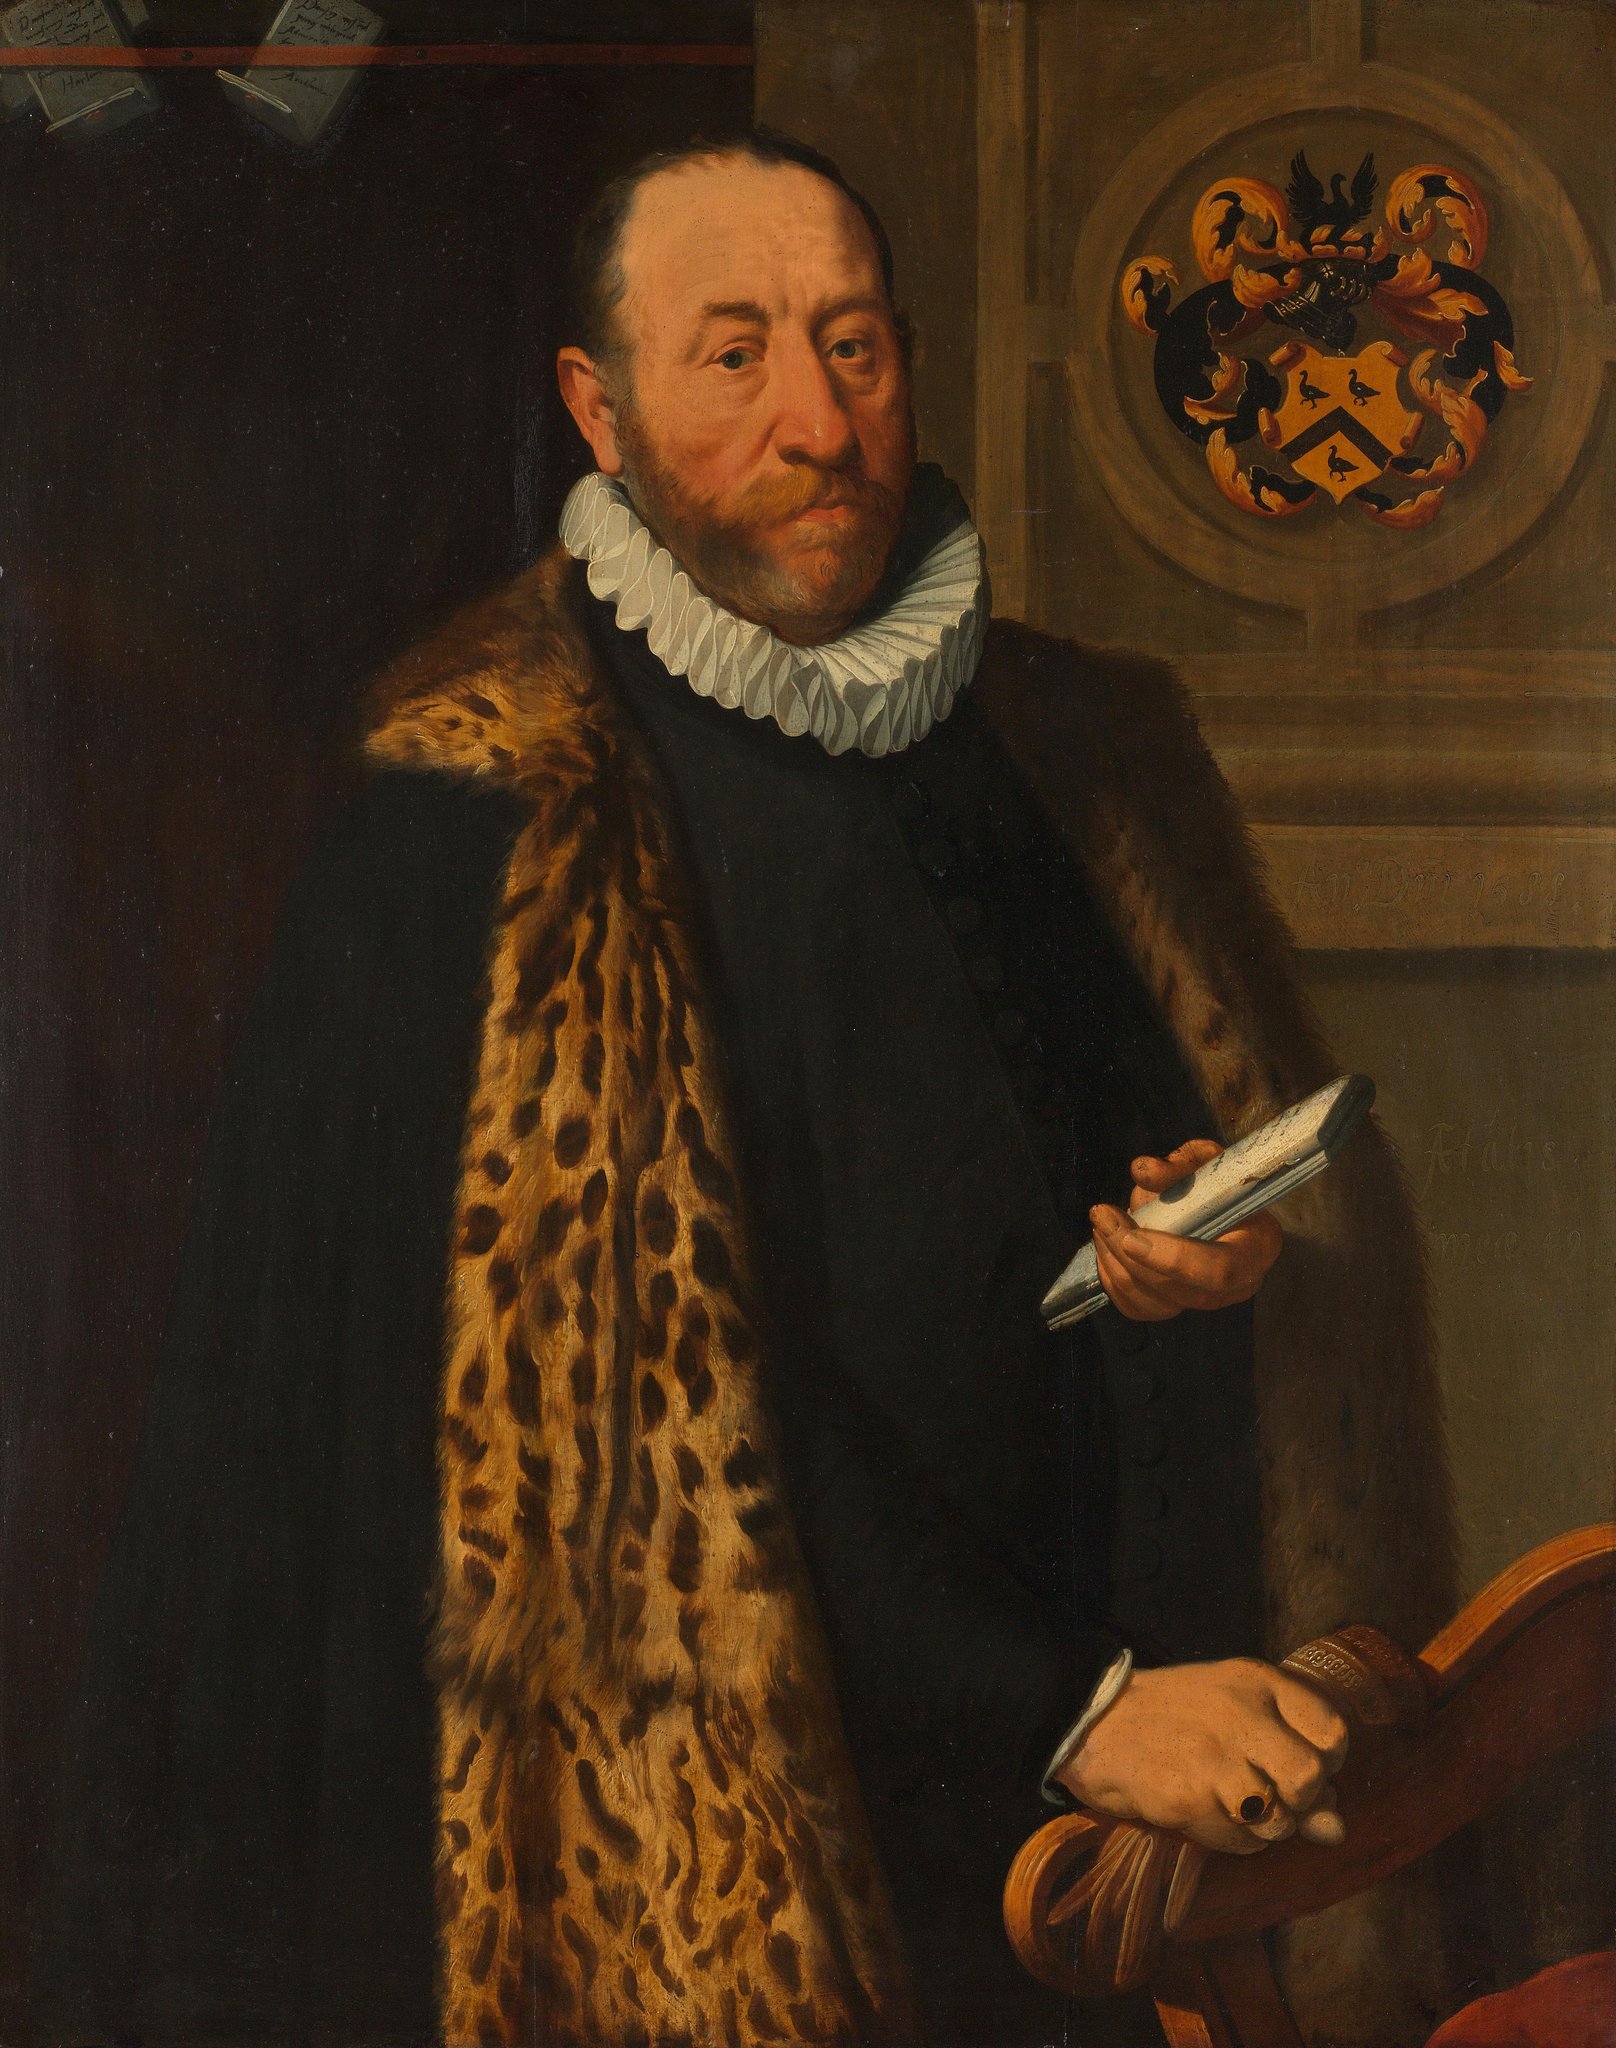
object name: painting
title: Portrait of Mattheus Augustijnsz Steyn, Councilor in the College of the Admiralty of the Northern Quarter in Dokkum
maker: pieter pietersz. (i)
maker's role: painter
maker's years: 1540-1603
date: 1588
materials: oil, panel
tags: historical persons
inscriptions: coat of arms, upper right: ‘In goud een lage keper vergezeld van drie eenden, alles zwart. Dekkleed met opgaande vogel (zwaan?)’, inscription and date: ‘Anº Dni 1588. AEtatis meae 49’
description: Pieter Pietersz (c. 1543-1603). Portrait of Mattheus Augustijnsz Steijn, 1588. Panel in the original oak frame, painted black and gold, Gift of M.C. van Houten, 1933.